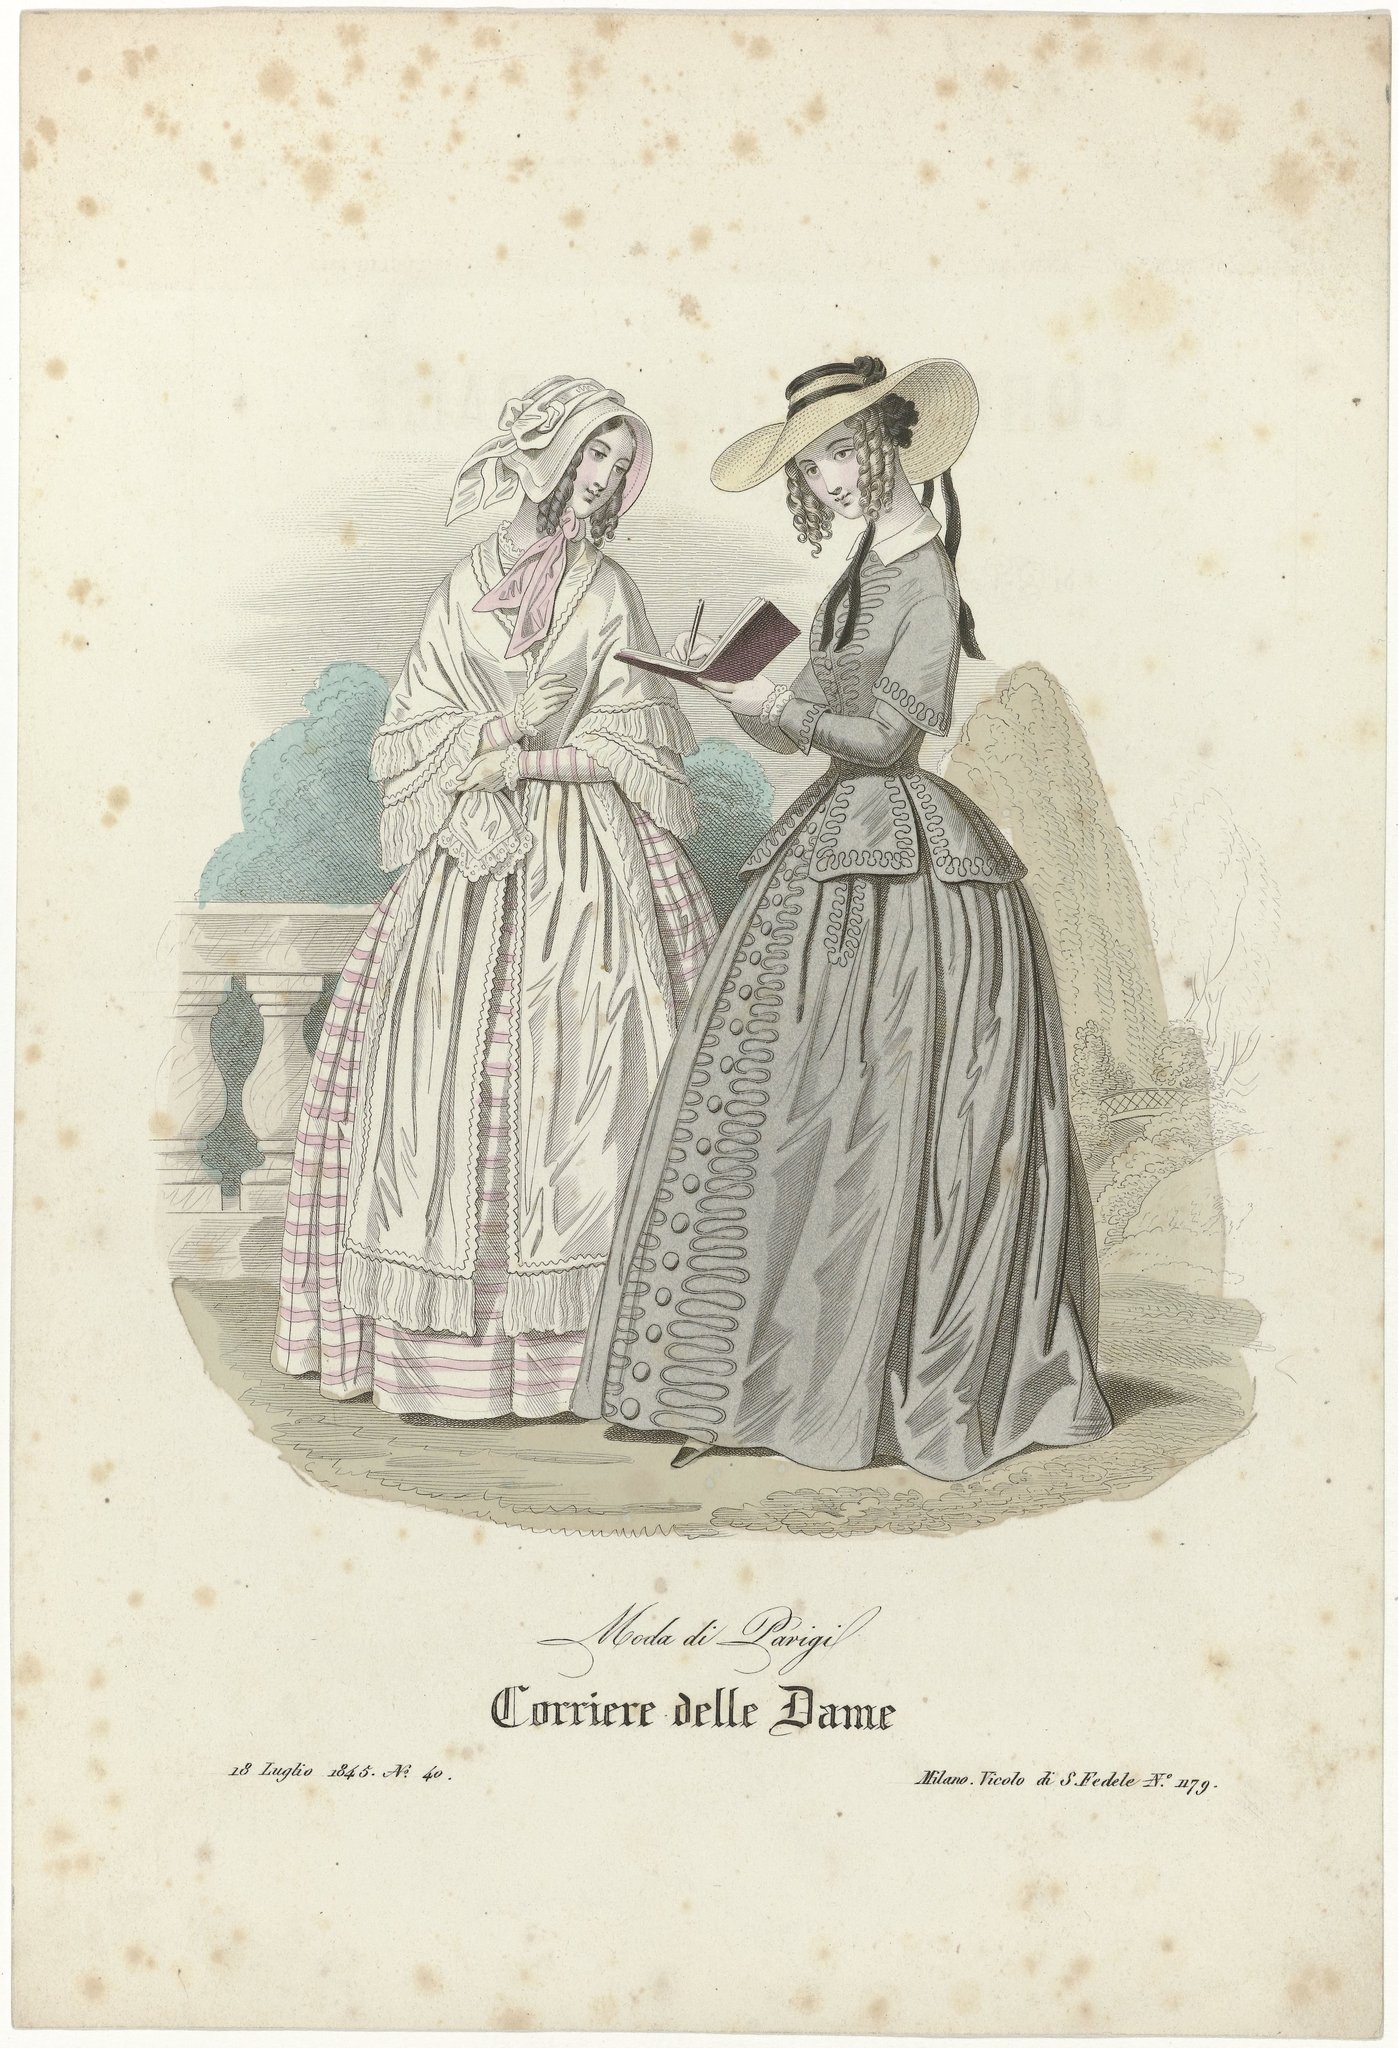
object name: fashion print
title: Corriere delle Dame, 18 Luglio (juli) 1845, No. 40 : Moda di Parigi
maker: Anonymous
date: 1845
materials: paper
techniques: engraving, hand coloring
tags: handwriting, writing as activity, clothing for the upper part of the body (+ women's clothes), handkerchief (+ women's clothes), clothing for the upper part of the body (mantelet) (+ women's clothes), fashion plates, head-gear: hat (+ women's clothes), skirt (+ women's clothes), dress, gown (+ women's clothes)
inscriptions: title: ‘Moda di Parigi / Corriere delle Dame’, address: ‘Milano. Vicolo di S Fedele No. 1179’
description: Mode uit Parijs. Prent uit het modetijdschrift Corriere delle Dame 1804-1872 (?).